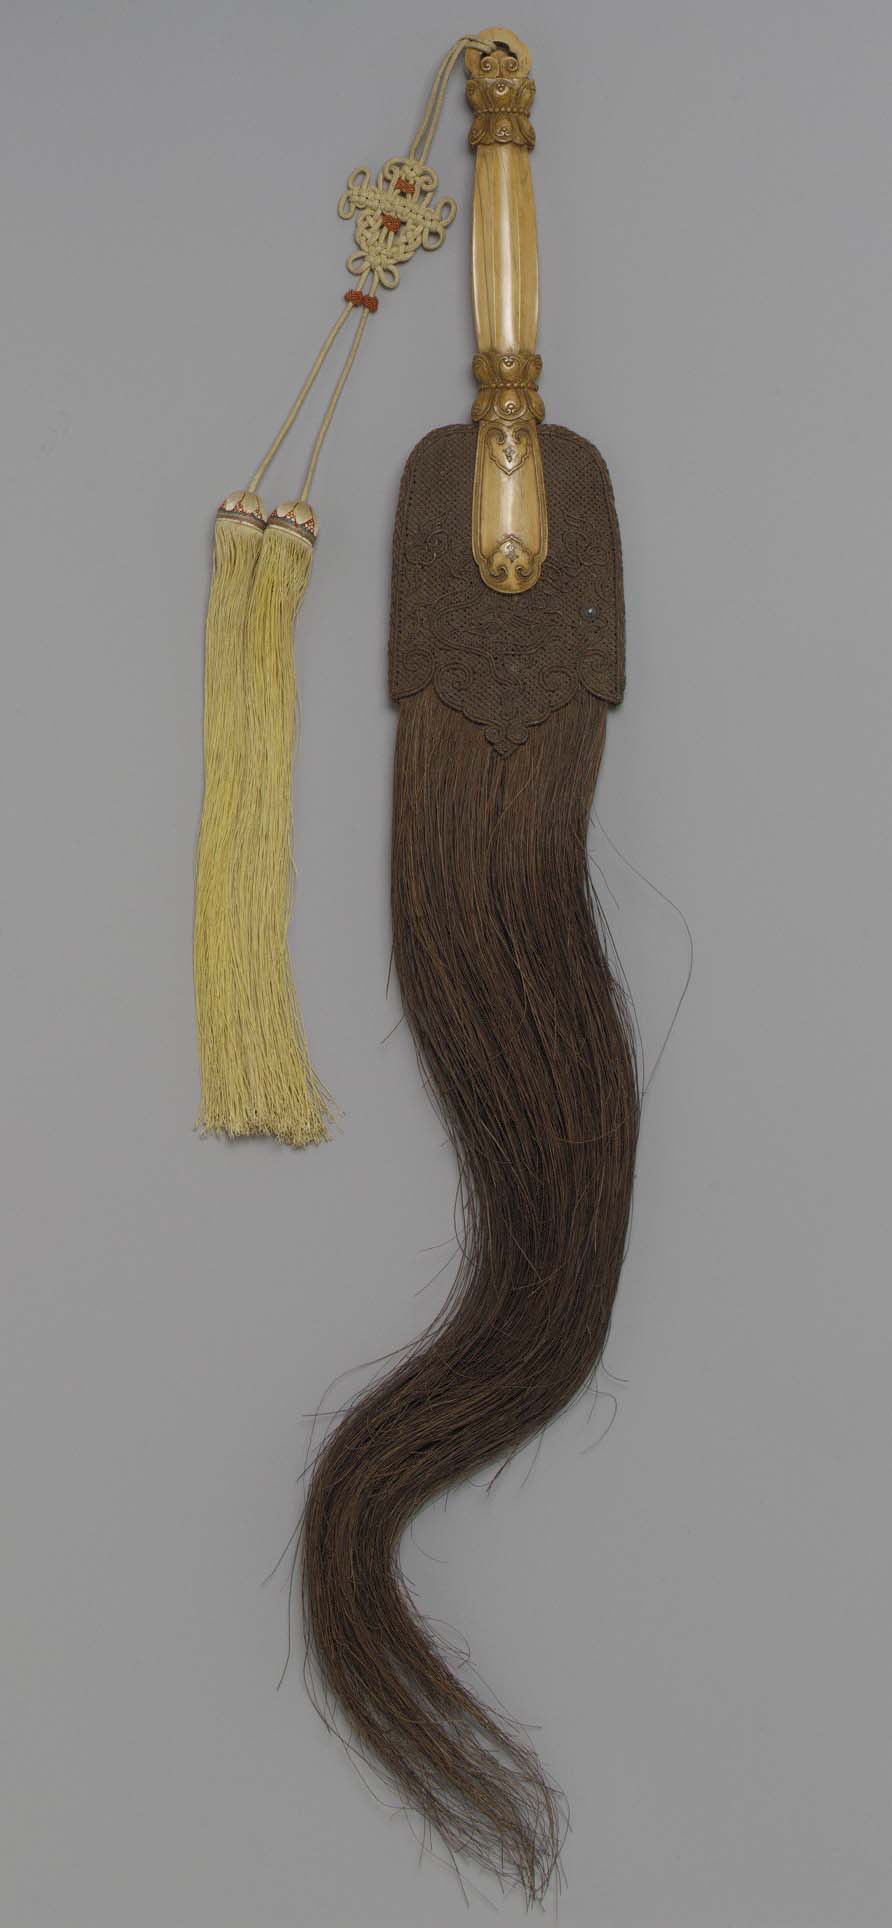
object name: fly whisk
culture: chinese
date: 1401-1500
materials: fiber, ivory, leaf, tin